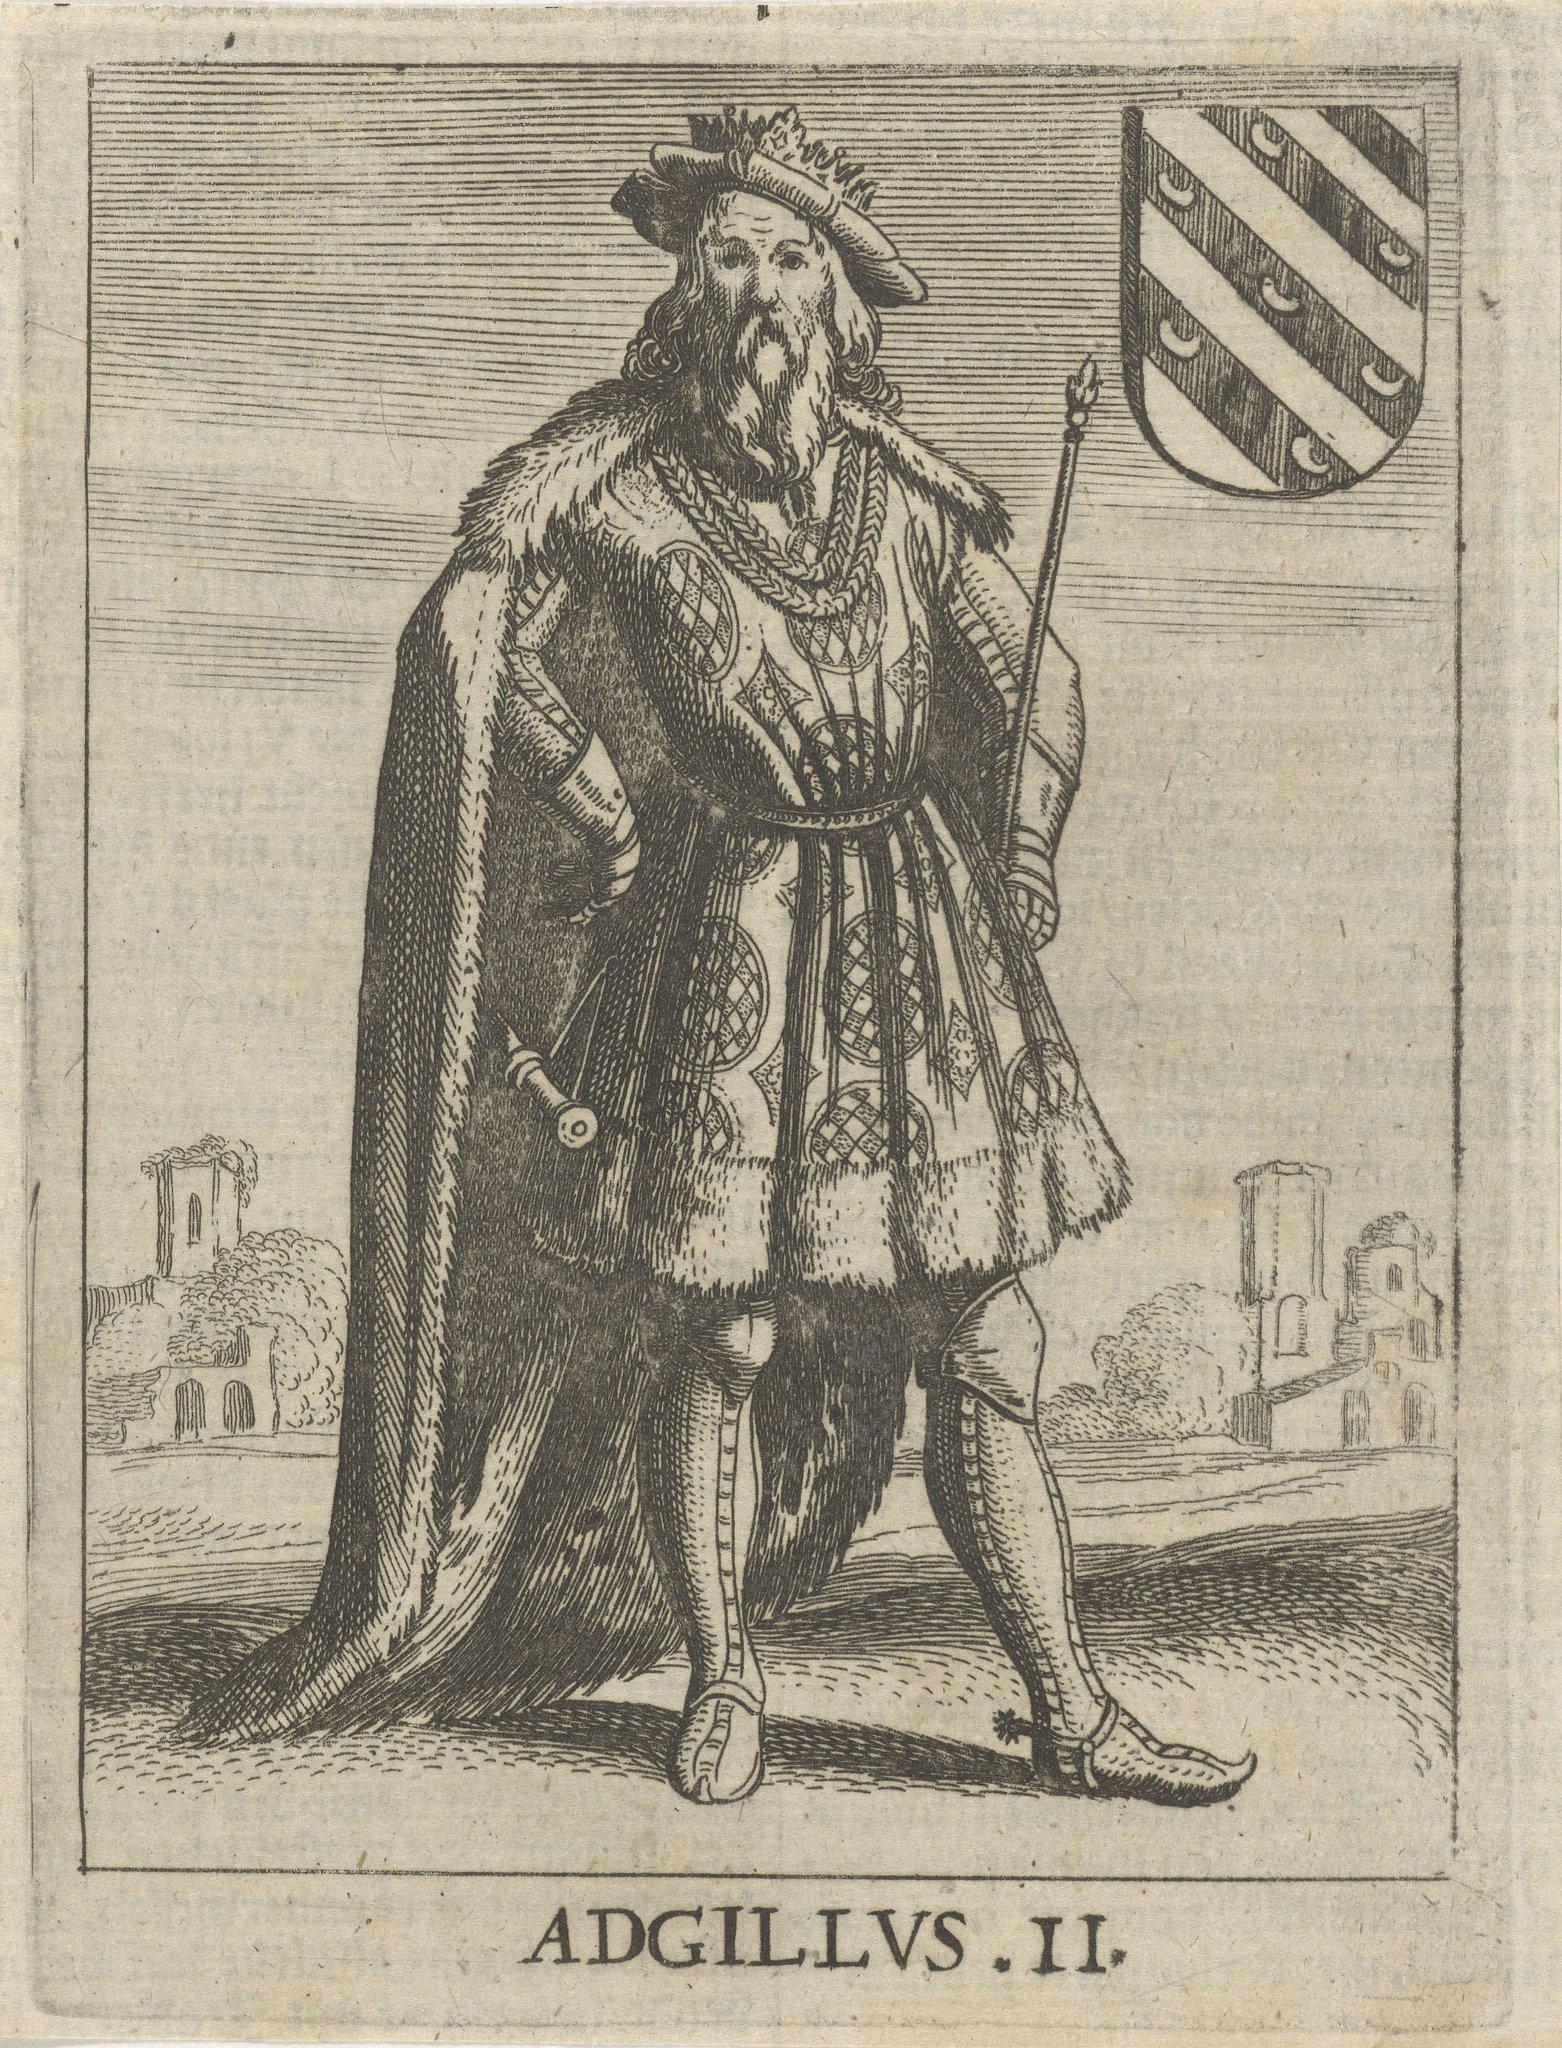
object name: book illustration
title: Adgillis II, zevende koning der Friezen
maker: pieter feddes van harlingen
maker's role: painter, print maker, publisher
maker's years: 1586-1623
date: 1611-1623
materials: paper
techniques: etching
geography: friesland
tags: adgilt ii (koning der friezen)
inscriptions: collector's mark: Lugt 2228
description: Adgillis II, zevende koning der Friezen, ten voeten uit, met kroon, mantel en in zijn linker hand een scepter. Achter hem enkele gebouwen en naast hem het wapen van Friesland.